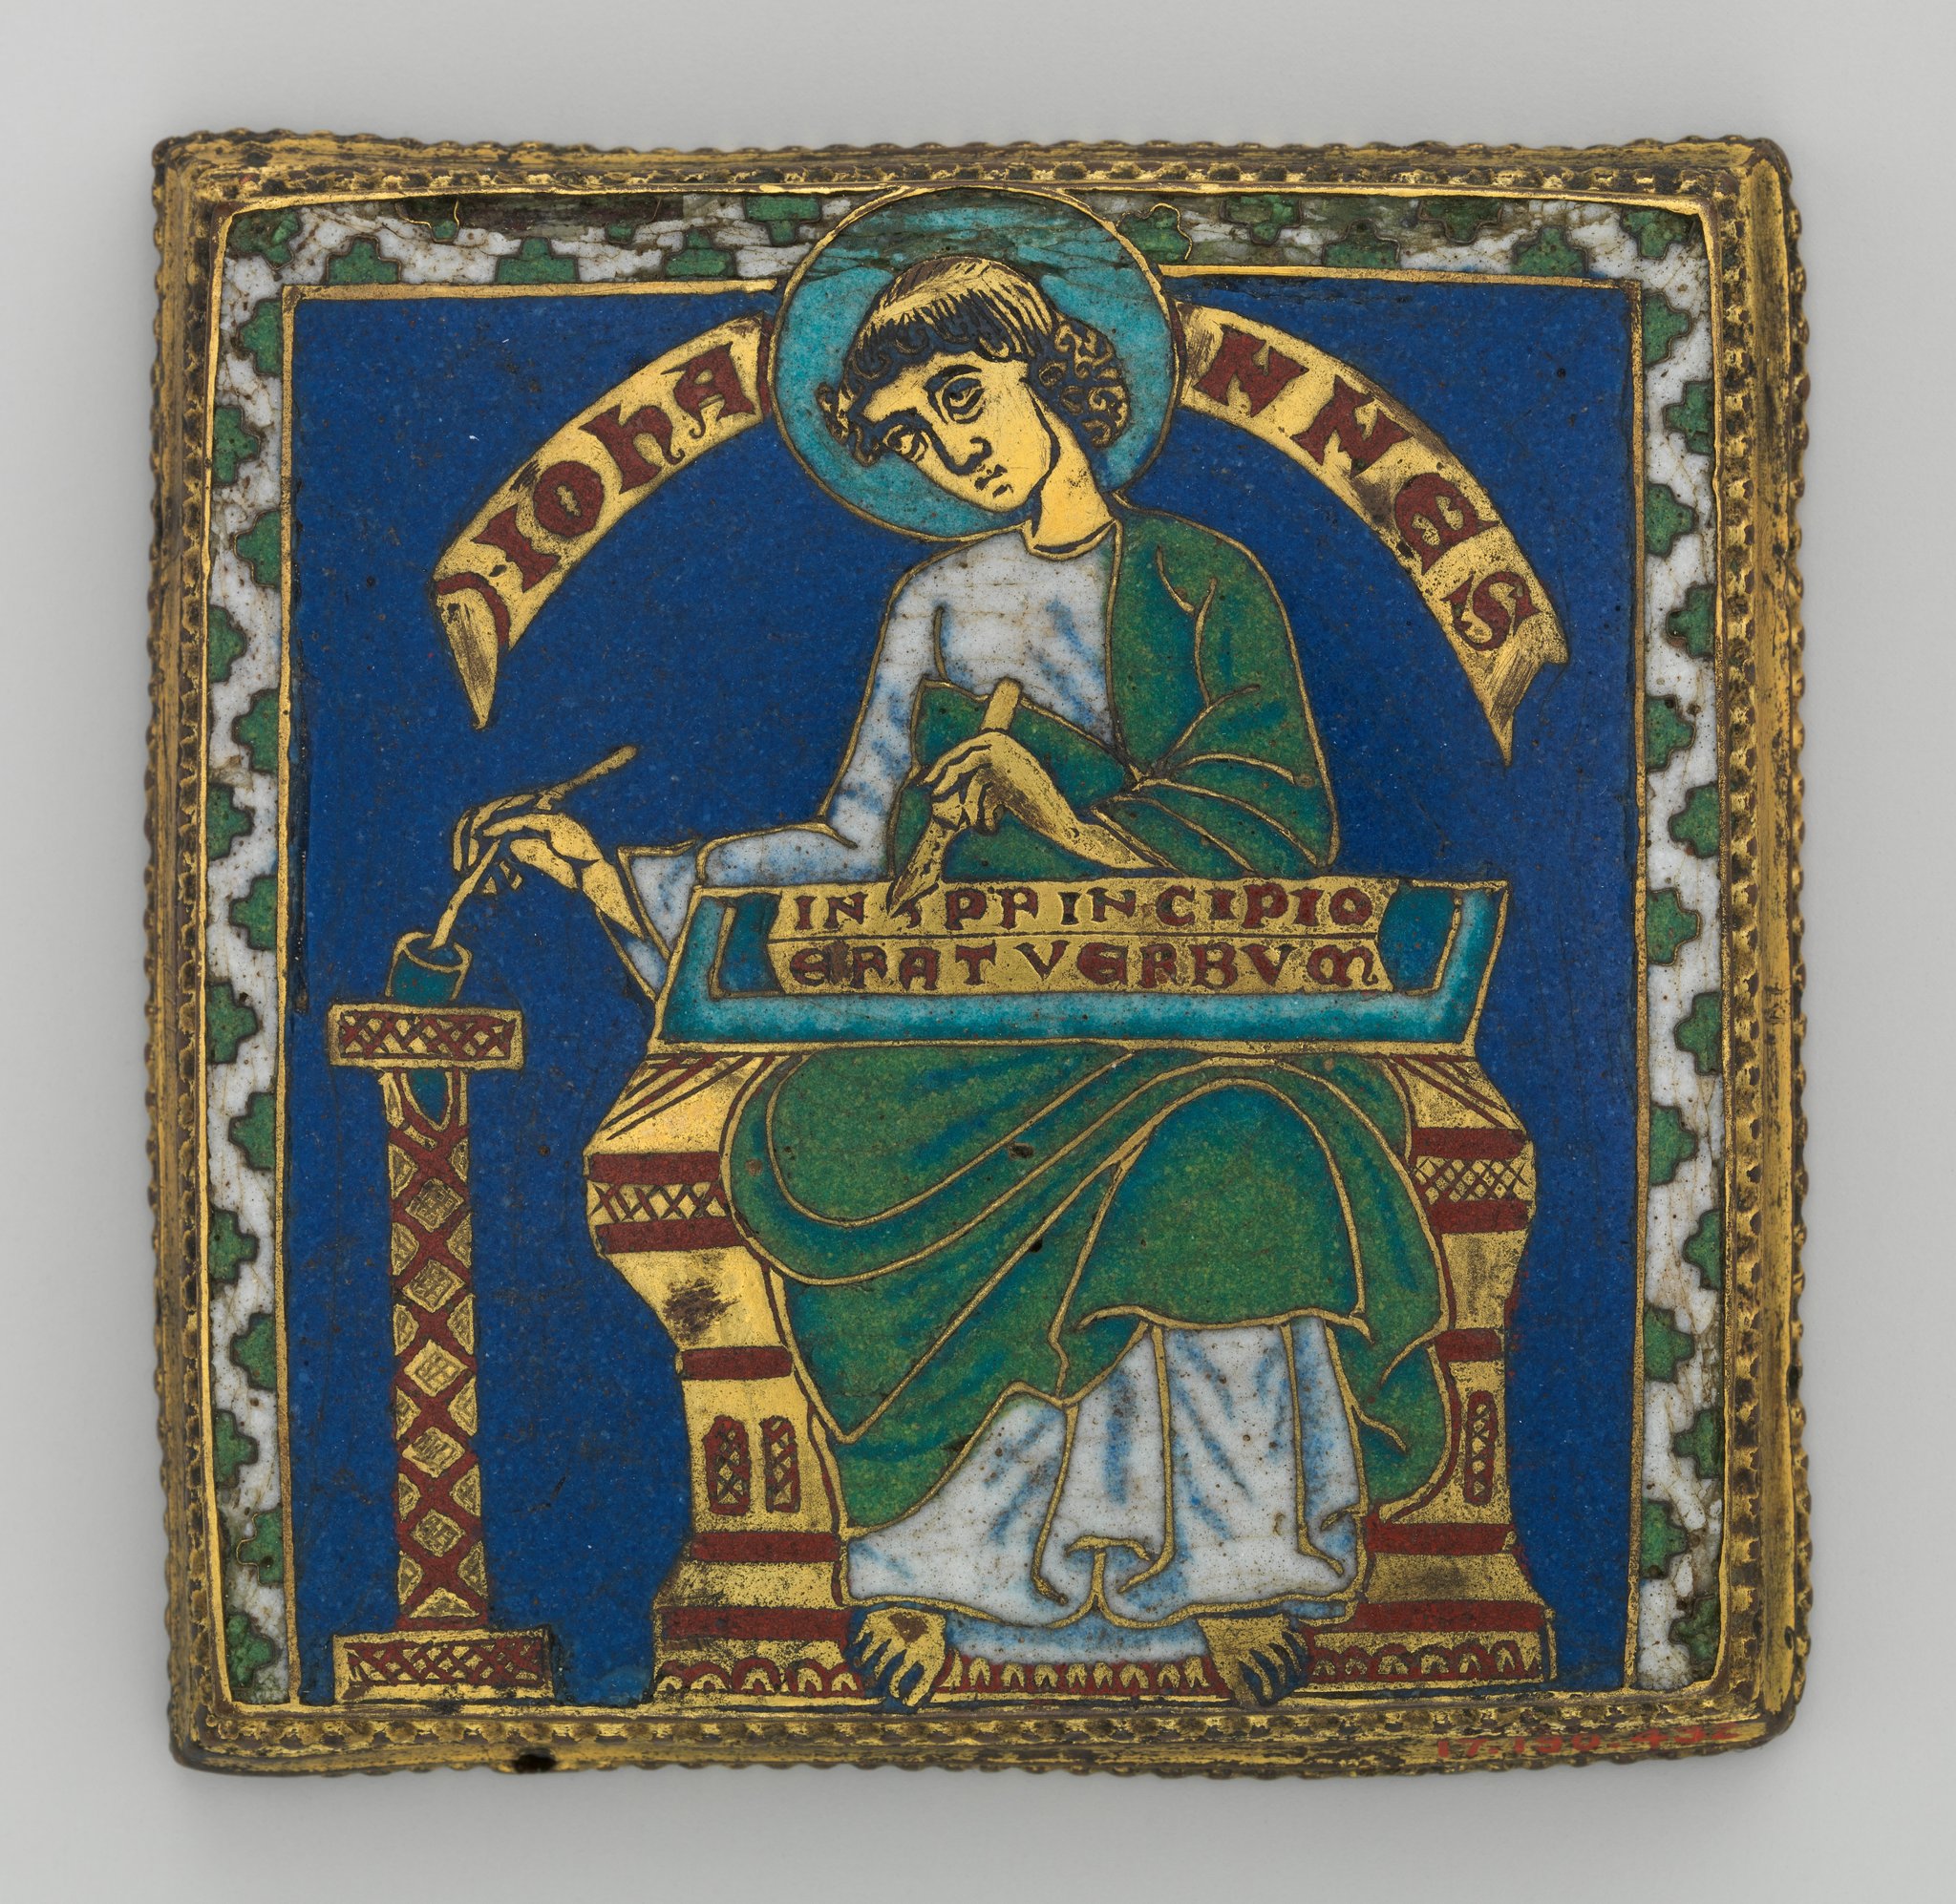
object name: plaque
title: Plaque with Saint John the Evangelist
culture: german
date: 1175-1200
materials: copper alloy, enamel, gilt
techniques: enamel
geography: germany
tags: saint john the evangelist,writing